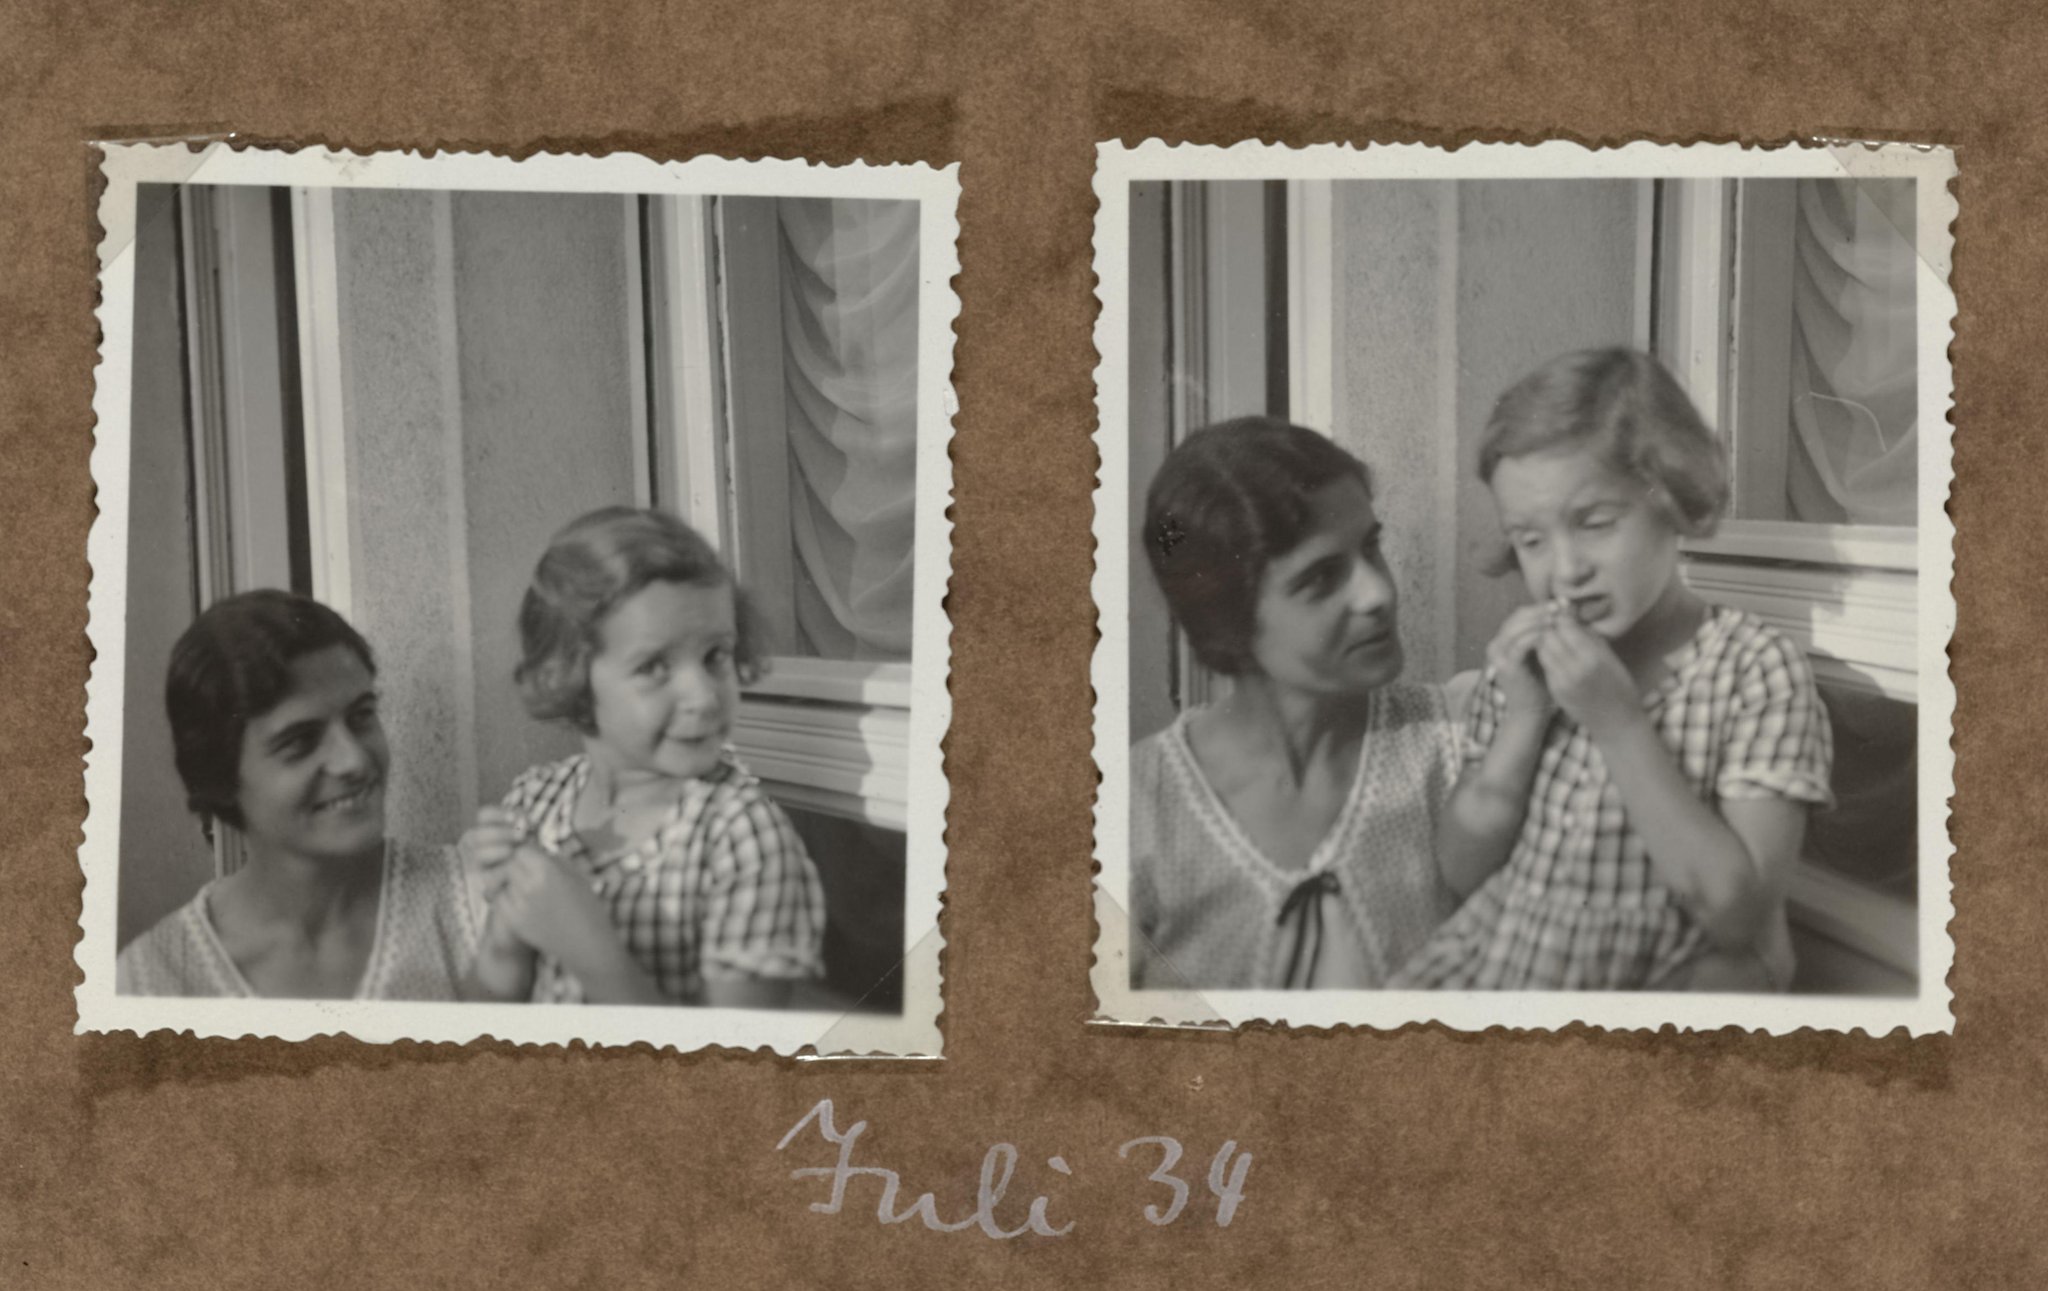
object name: photograph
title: Isabel Wachenheimer en een lid van de huishoudelijke staf, juli 1934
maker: Anonymous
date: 1907-1934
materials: photographic support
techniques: gelatin silver print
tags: leiden, isabel wachenheimer-elon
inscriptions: date: ‘Juli 34’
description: Isabel Wachenheimer en een onbekend lid van de huishoudelijke staf.